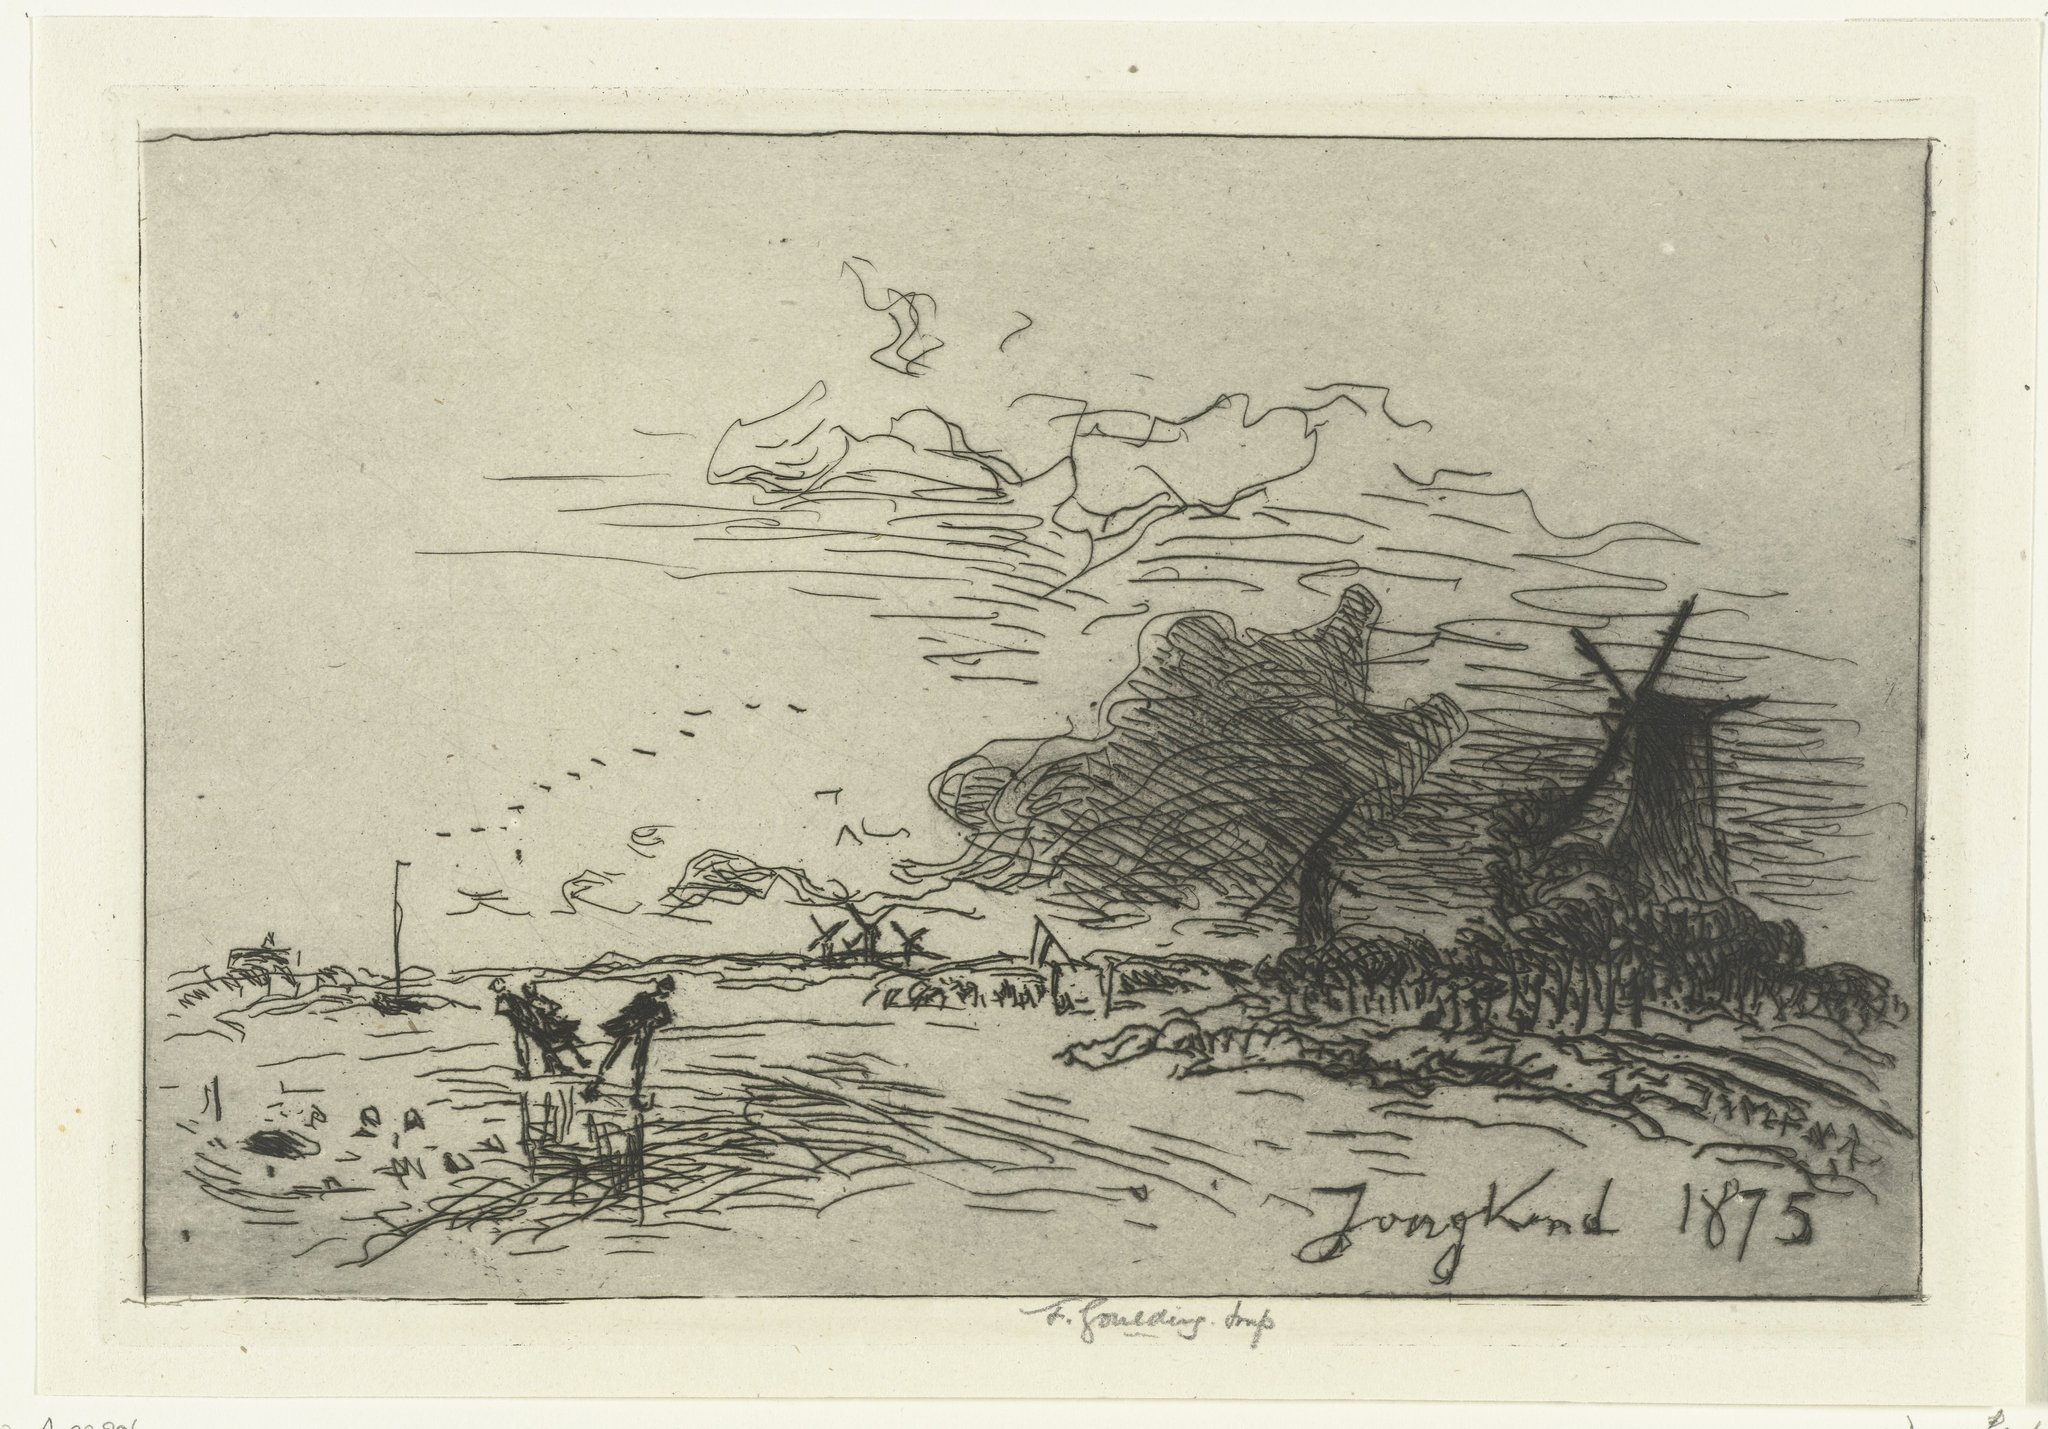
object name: print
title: Winterlandschap nabij Rotterdam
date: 1875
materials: paper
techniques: etching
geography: london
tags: landscapes in the temperate zone, windmill in landscape, skates (winter sports), rotterdam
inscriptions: collector's mark: Lugt 2228a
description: Schaatsers op een kanaal nabij Rotterdam, waaraan een molen staat. Op de achtergrond nog een aantal molens.